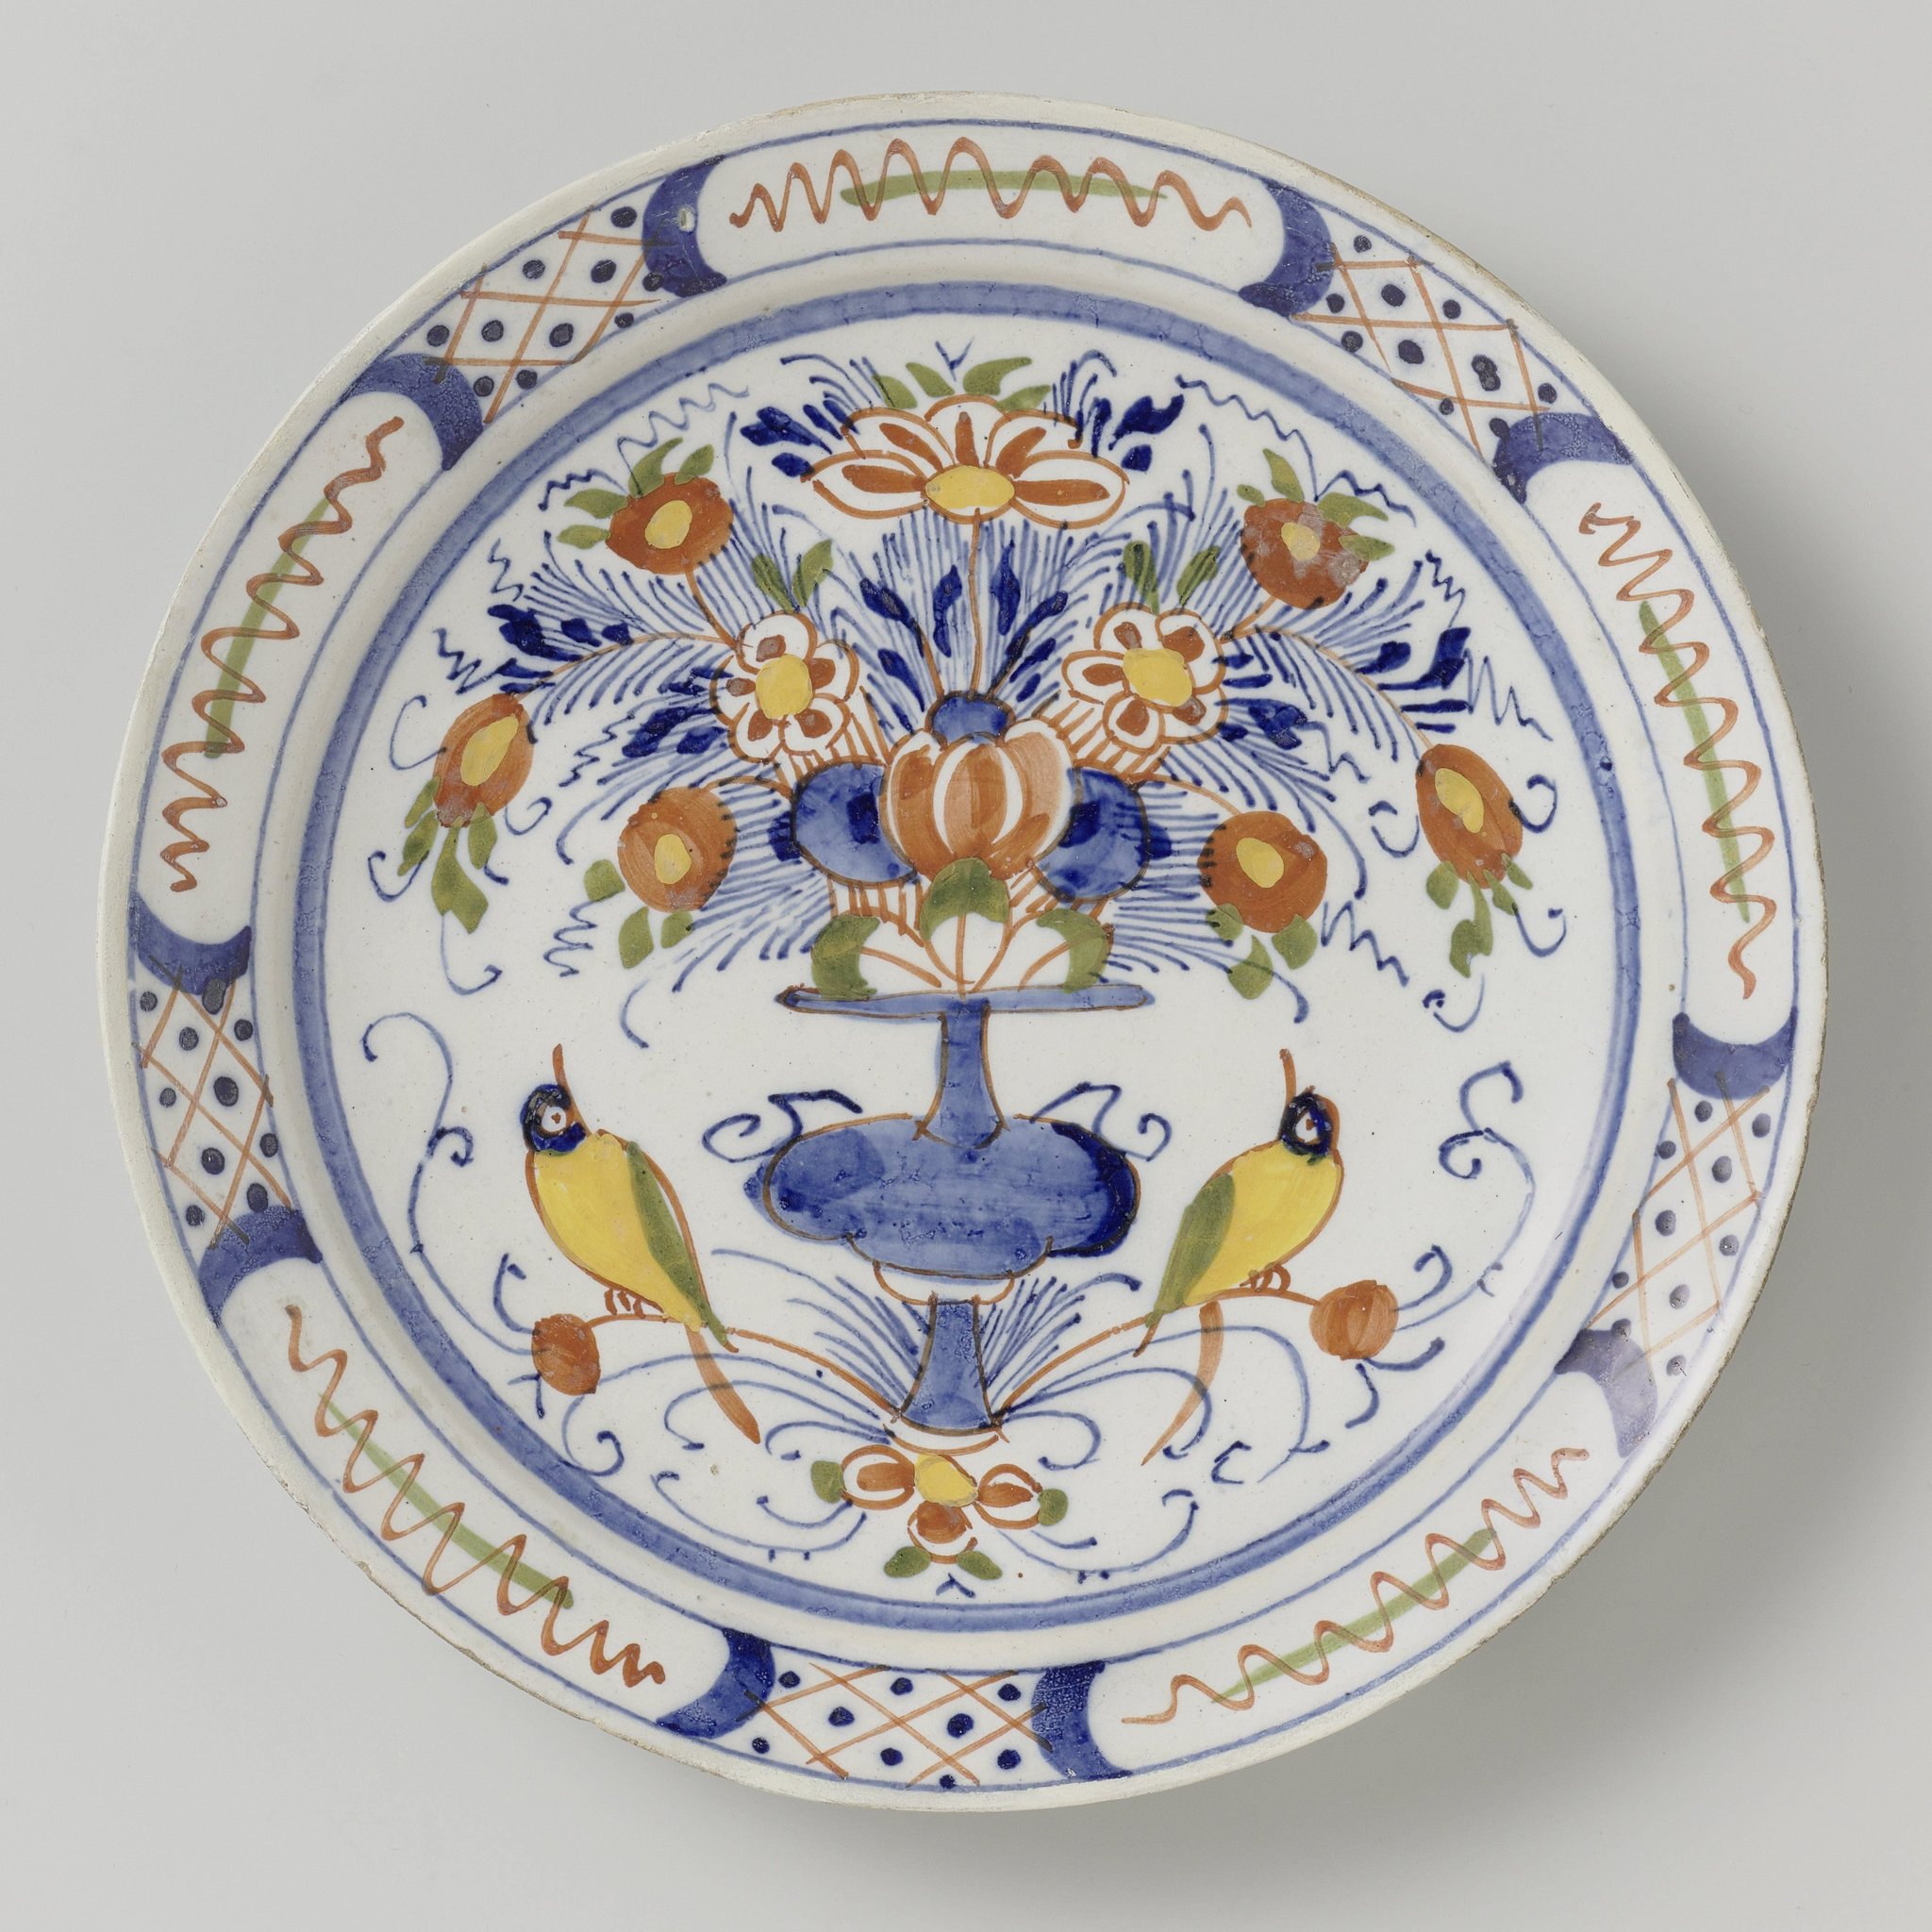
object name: plate dish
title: bord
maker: Anonymous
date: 1750-1780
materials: earthenware, glaze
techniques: painted, polychromy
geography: delft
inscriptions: collector's mark: ‘koninklijk oudheidkundig genootschap no. 38’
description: Rond bord van veelkleurig beschilderde faience. Op het plat zijn een bloemenvaas en twee vogels geschilderd en op de rand een Chinees motief. Bij het bord horen drie identieke borden met de invnrs. BK-KOG-2424-a, BK-KOG-2424-b en BK-KOG-2424-c.